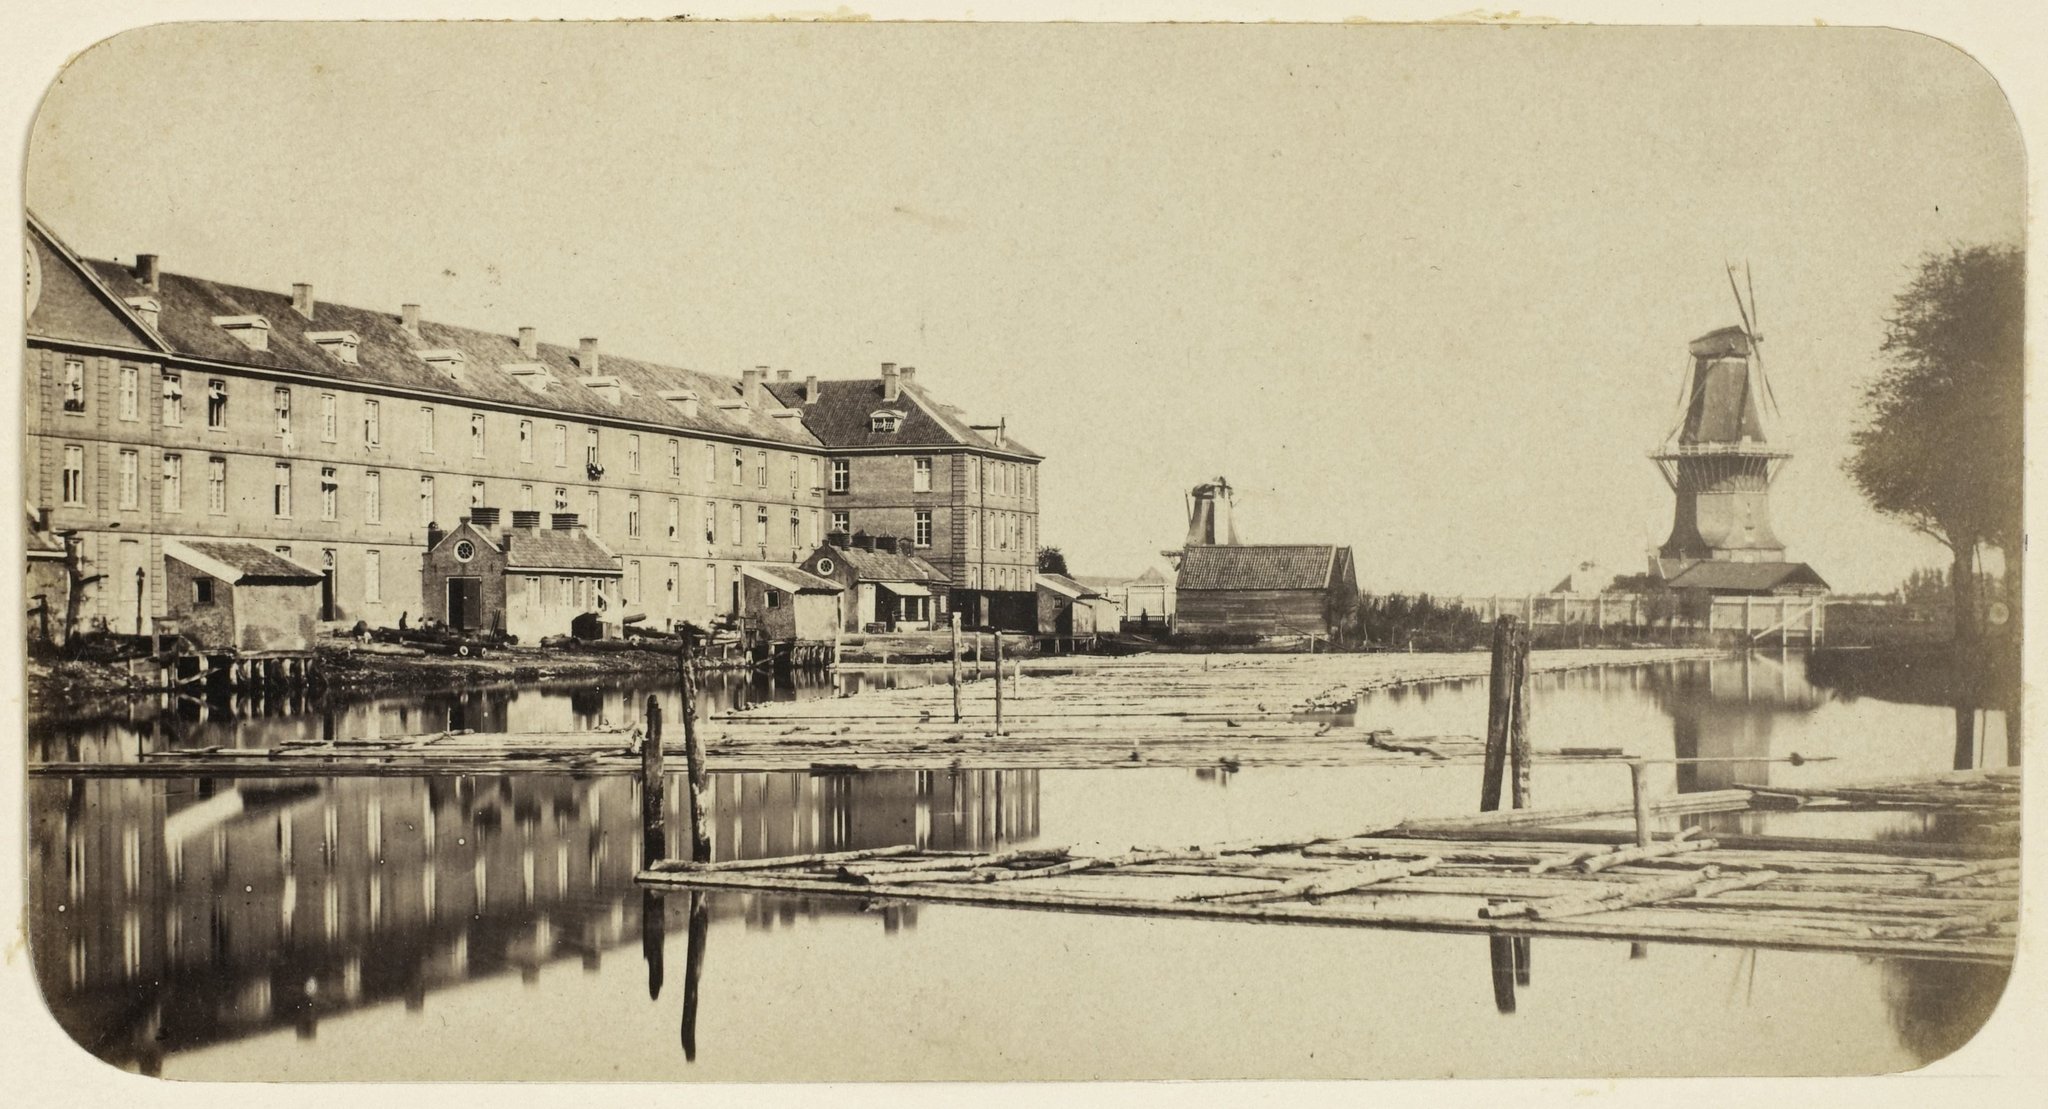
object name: photograph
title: Gezicht op de Oranje-Nassau-kazerne in Amsterdam gezien vanaf de garancinefabriek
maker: eduard isaac asser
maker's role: amateurfotograaf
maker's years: 1809-1894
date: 1852-1854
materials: cardboard, paper, photographic support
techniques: salted paper print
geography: amsterdam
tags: amsterdam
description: De achterzijde van de Oranje Nassaukazerne, gezien vanuit de tuin van de garancinefabriek van Mendel Bour en Co. Het terrein van de fabriek strekte zich uit tit de punt van het bolwerk Oetewaal, waar Asser zijn camera opstelde. Asser was goed bevriend met ingenieur Marie Eugène Bour. Op de voorgrond de Singelgracht, die hier gebruikt werd als ligplaats van houtvlotten. Rechts de nog steeds bestaande korenmolen De Gooyer en middenachter de loodwitmolen De Zon, die in 1856 is afgebroken.